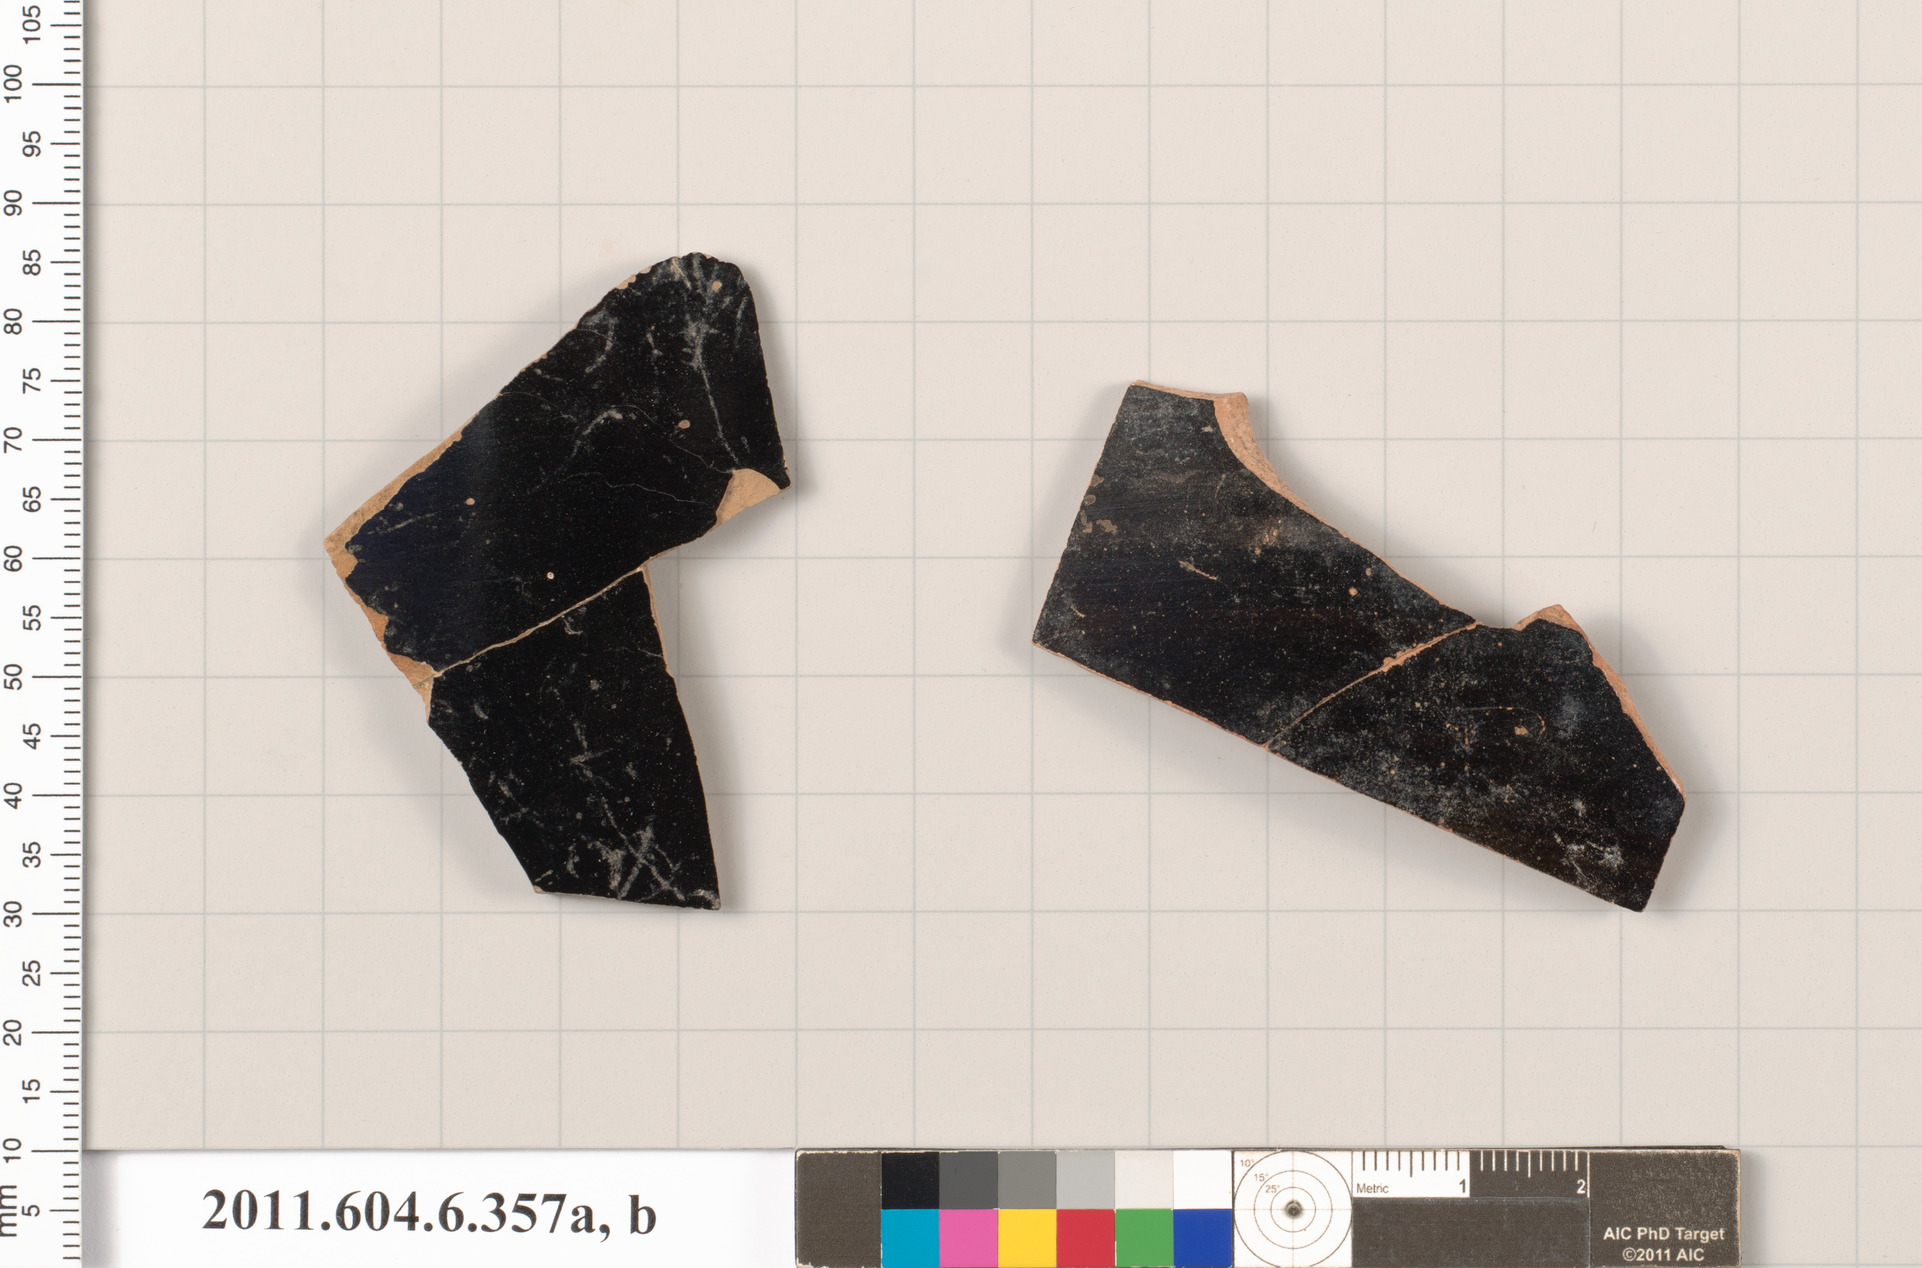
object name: undetermined closed shape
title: Terracotta fragments of closed shapes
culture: greek, attic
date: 600-401 BCE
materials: terracotta